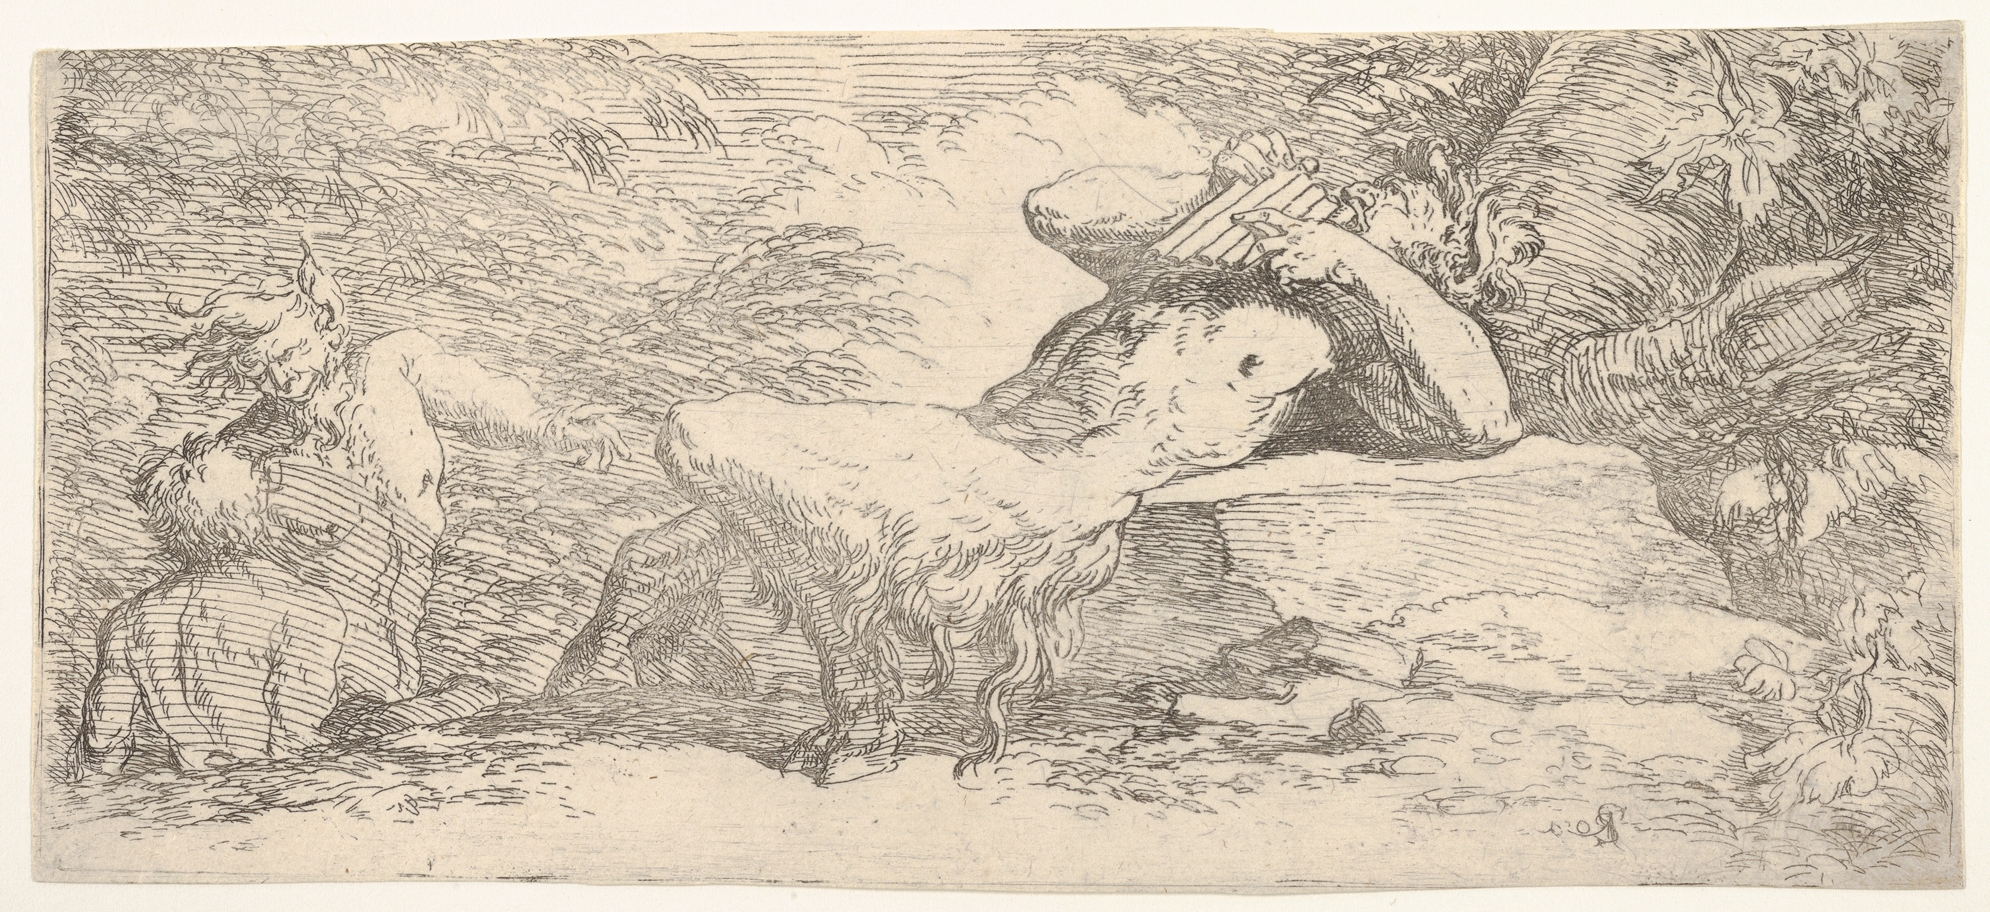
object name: print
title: Piping satyr and two fauns, from "The Triton Group"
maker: salvator rosa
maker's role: artist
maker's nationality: italian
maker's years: 1615-1673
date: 1660-1661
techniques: drypoint, etching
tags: fauns,satyrs